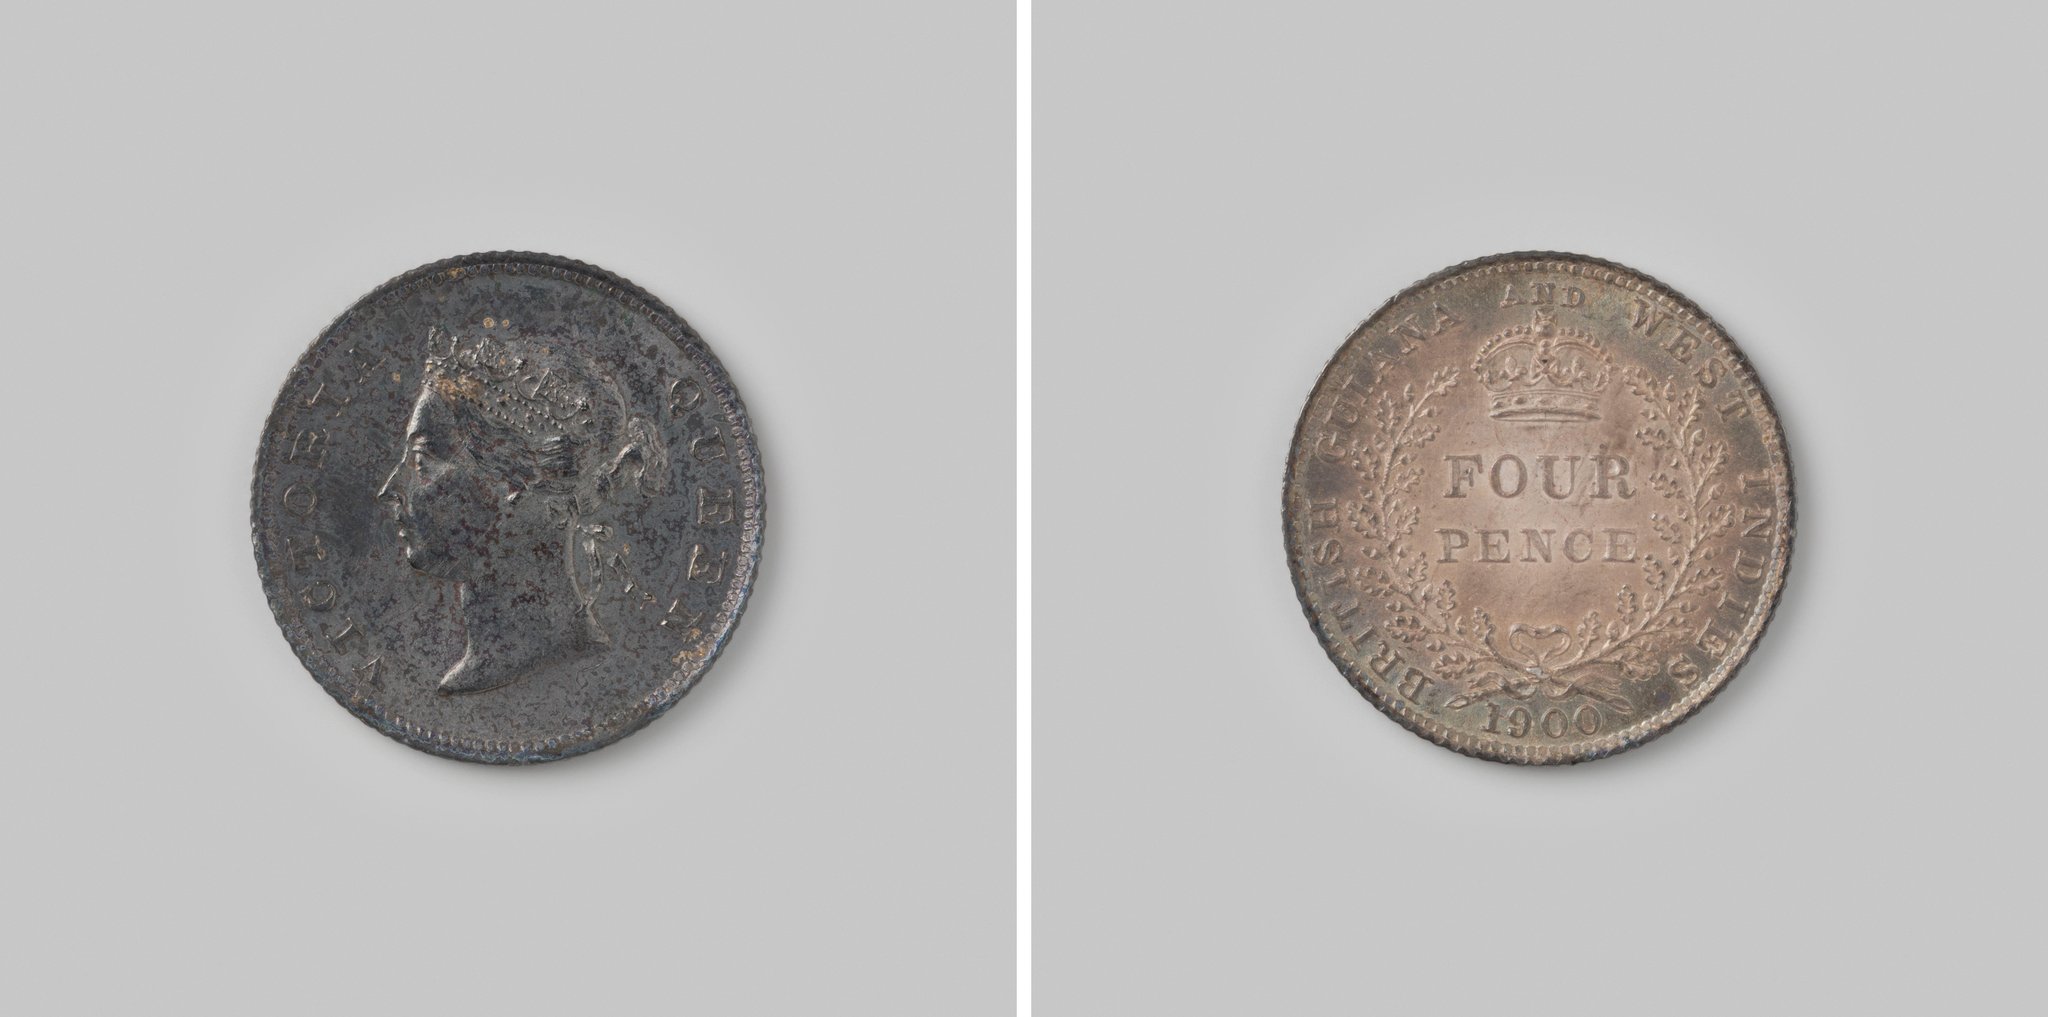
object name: coin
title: 4 pence uit Brits Guiana en West-Indië van koningin Victoria, 1900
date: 1900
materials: silver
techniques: striking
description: Zilveren munt. Voorzijde: gekroond hoofd van de koningin naar links. Keerzijde: tussen twee samengebonden takken waarde-aanduiding in twee regels, waarboven kroon. Jaartal onderaan in omschrift. Kartelrand.